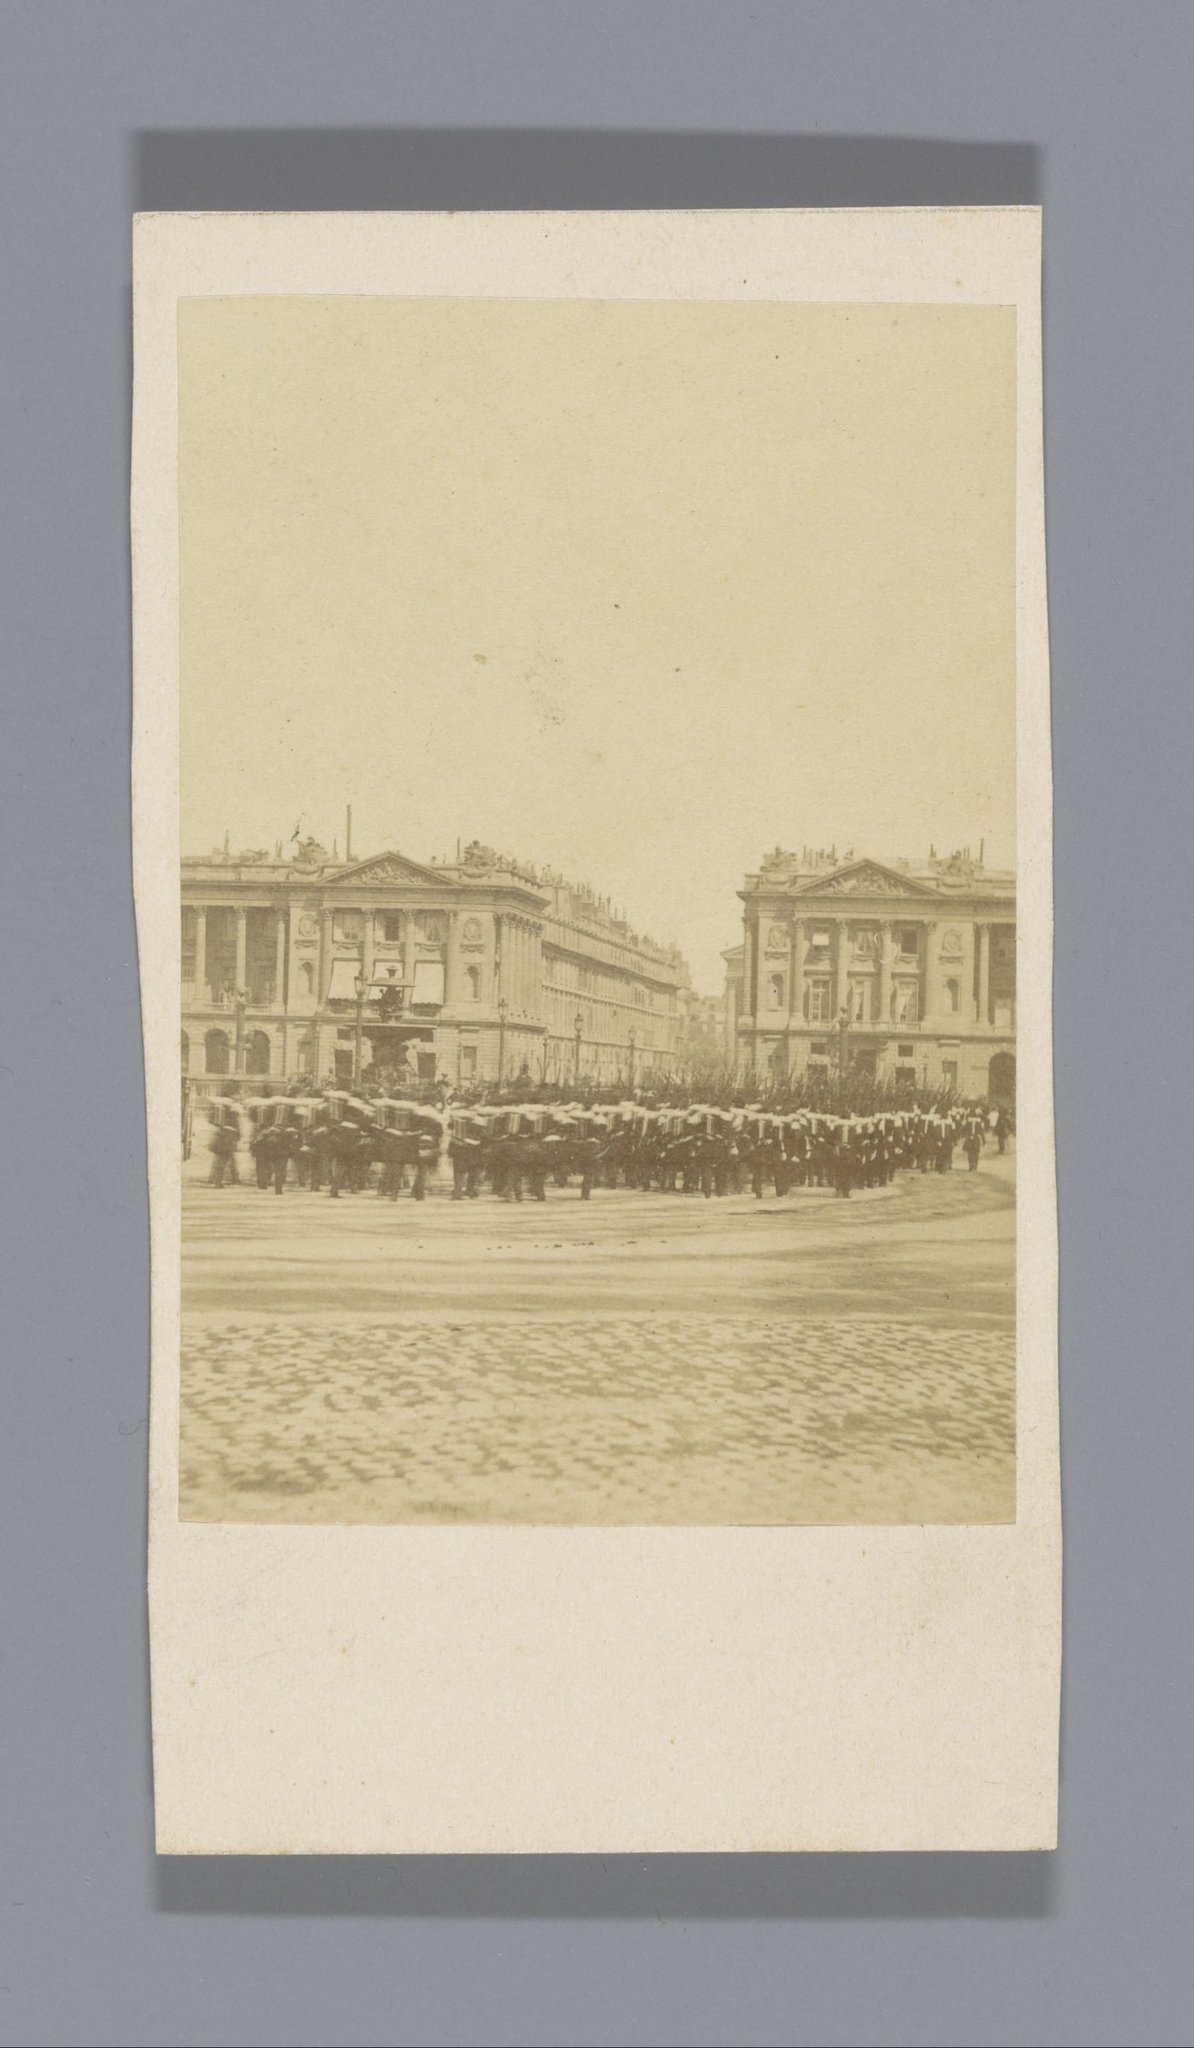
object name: carte de visite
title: Militaire parade op het Place de la Concorde, Parijs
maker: Anonymous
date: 1865-1870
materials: cardboard, paper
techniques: albumen print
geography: paris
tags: square, place, circus, etc., military parade, pageant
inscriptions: inscription: ‘Place de la Concorde/ Paris’